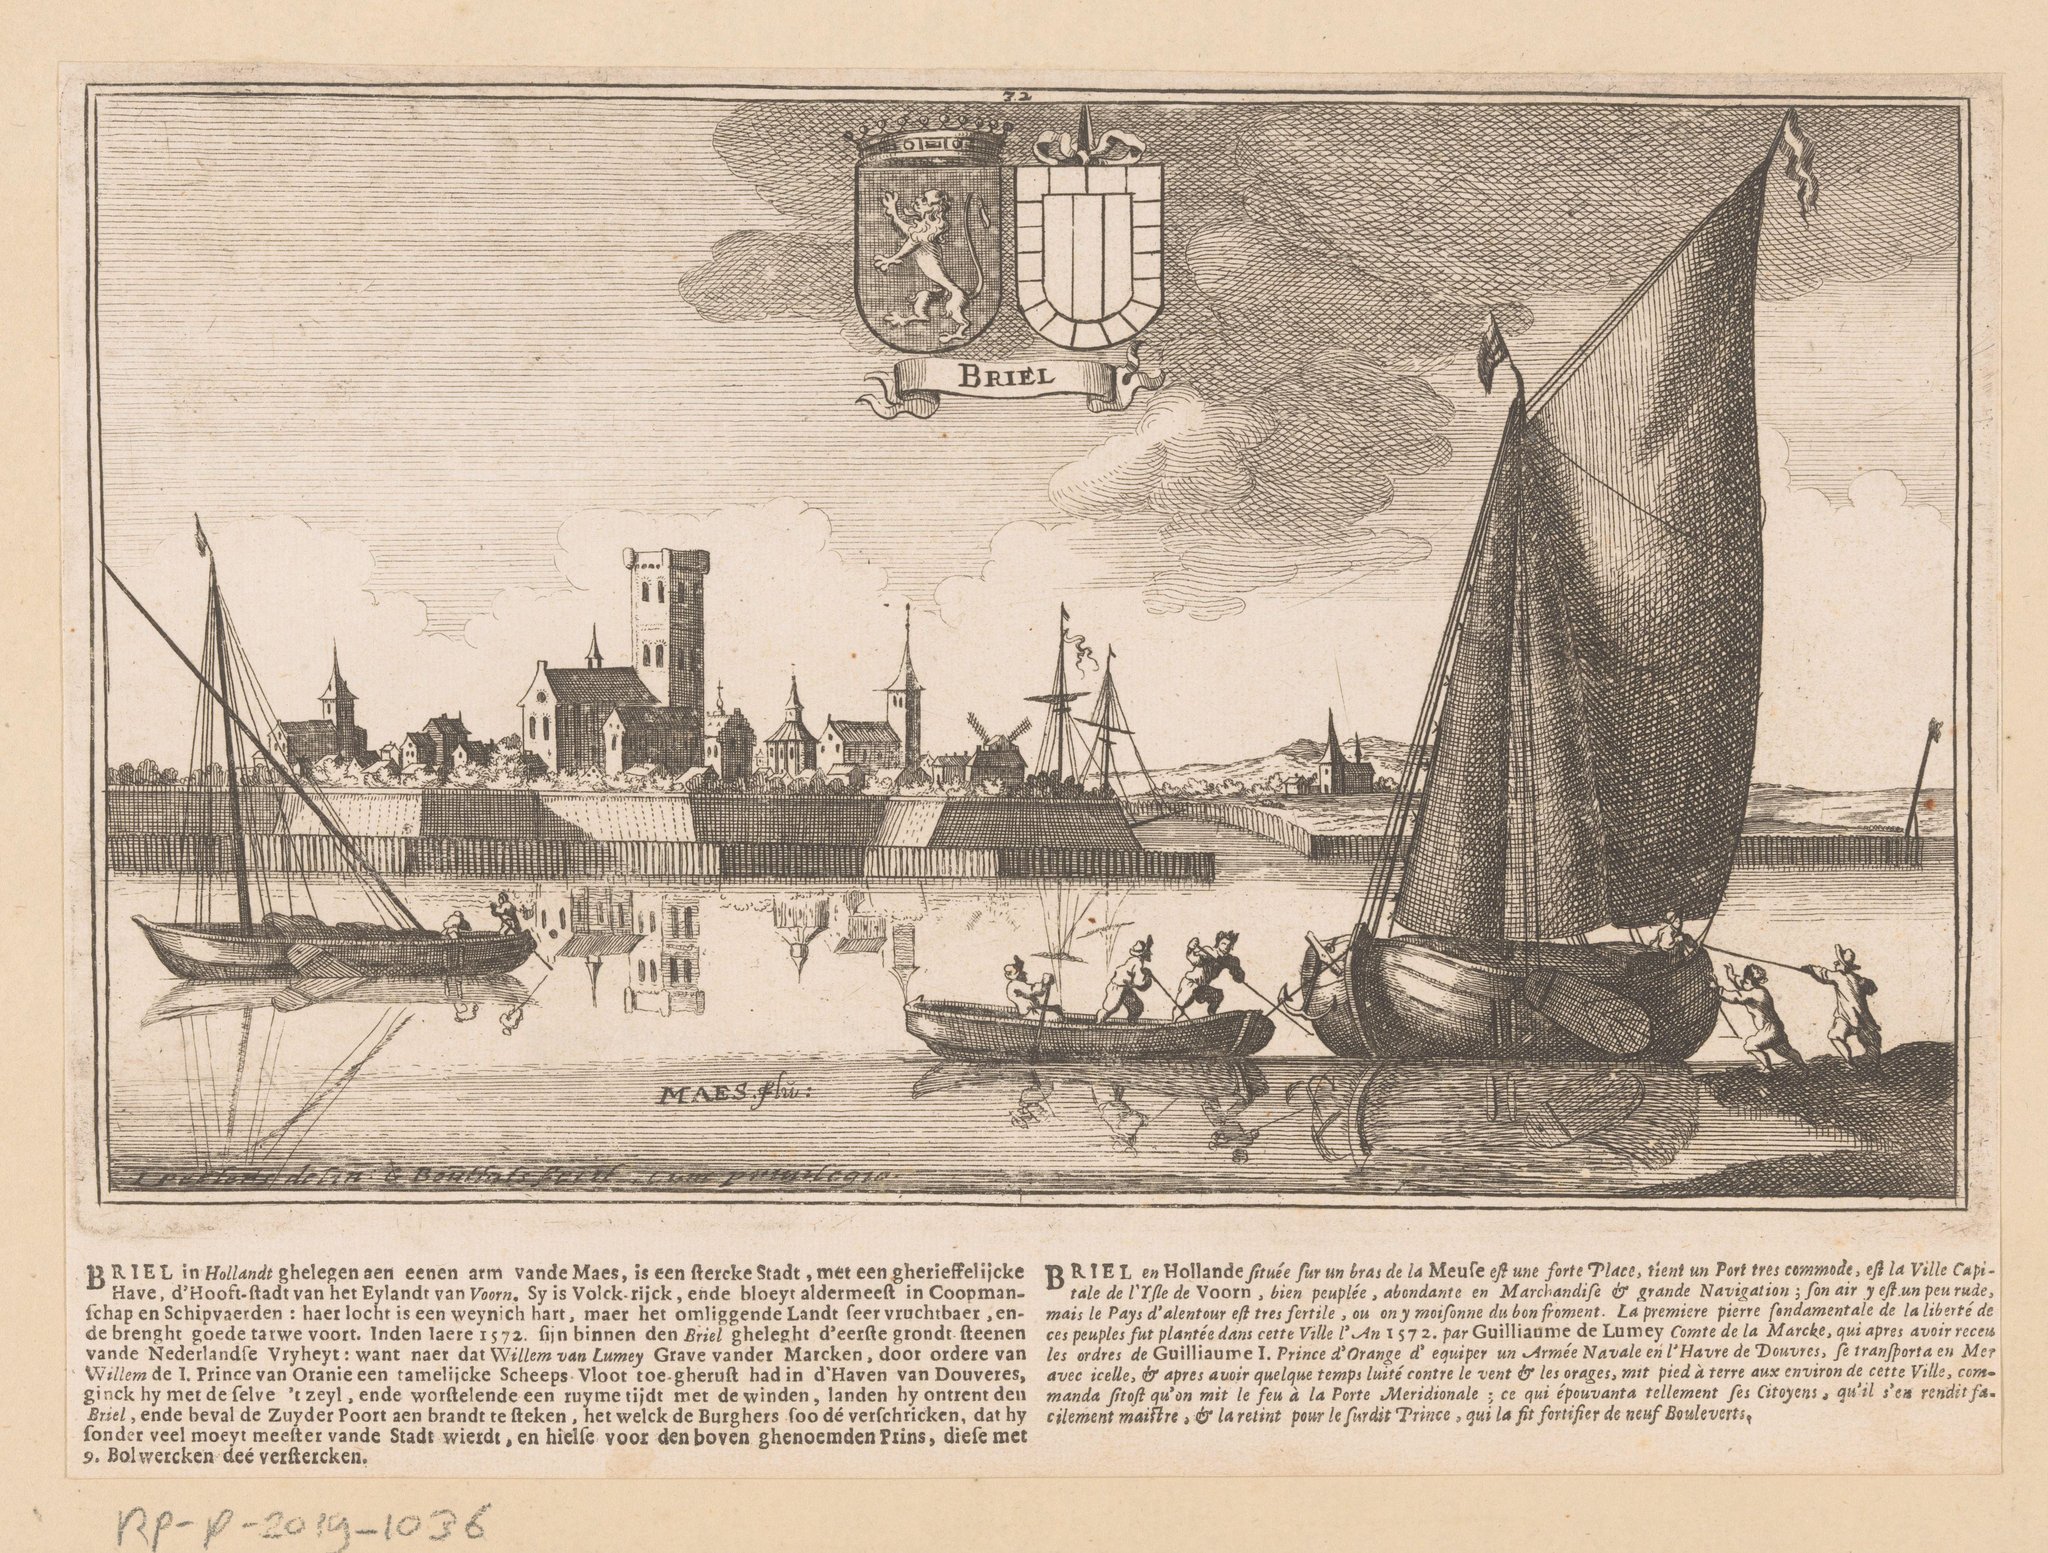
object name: print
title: Briel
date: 1674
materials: paper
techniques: engraving, etching, letterpress printing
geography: brielle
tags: ships (in general), harbour (+ number of persons ~ traffic and transport), brielle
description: Prent uit: Peeters, Jan. Thooneel der steden ende sterckten van t'Vereenight Nederlandt (...) / Theatre des villes et fortresses des Provinces Unies (...). Antwerpen: Gaspar Bouttats, 1674.